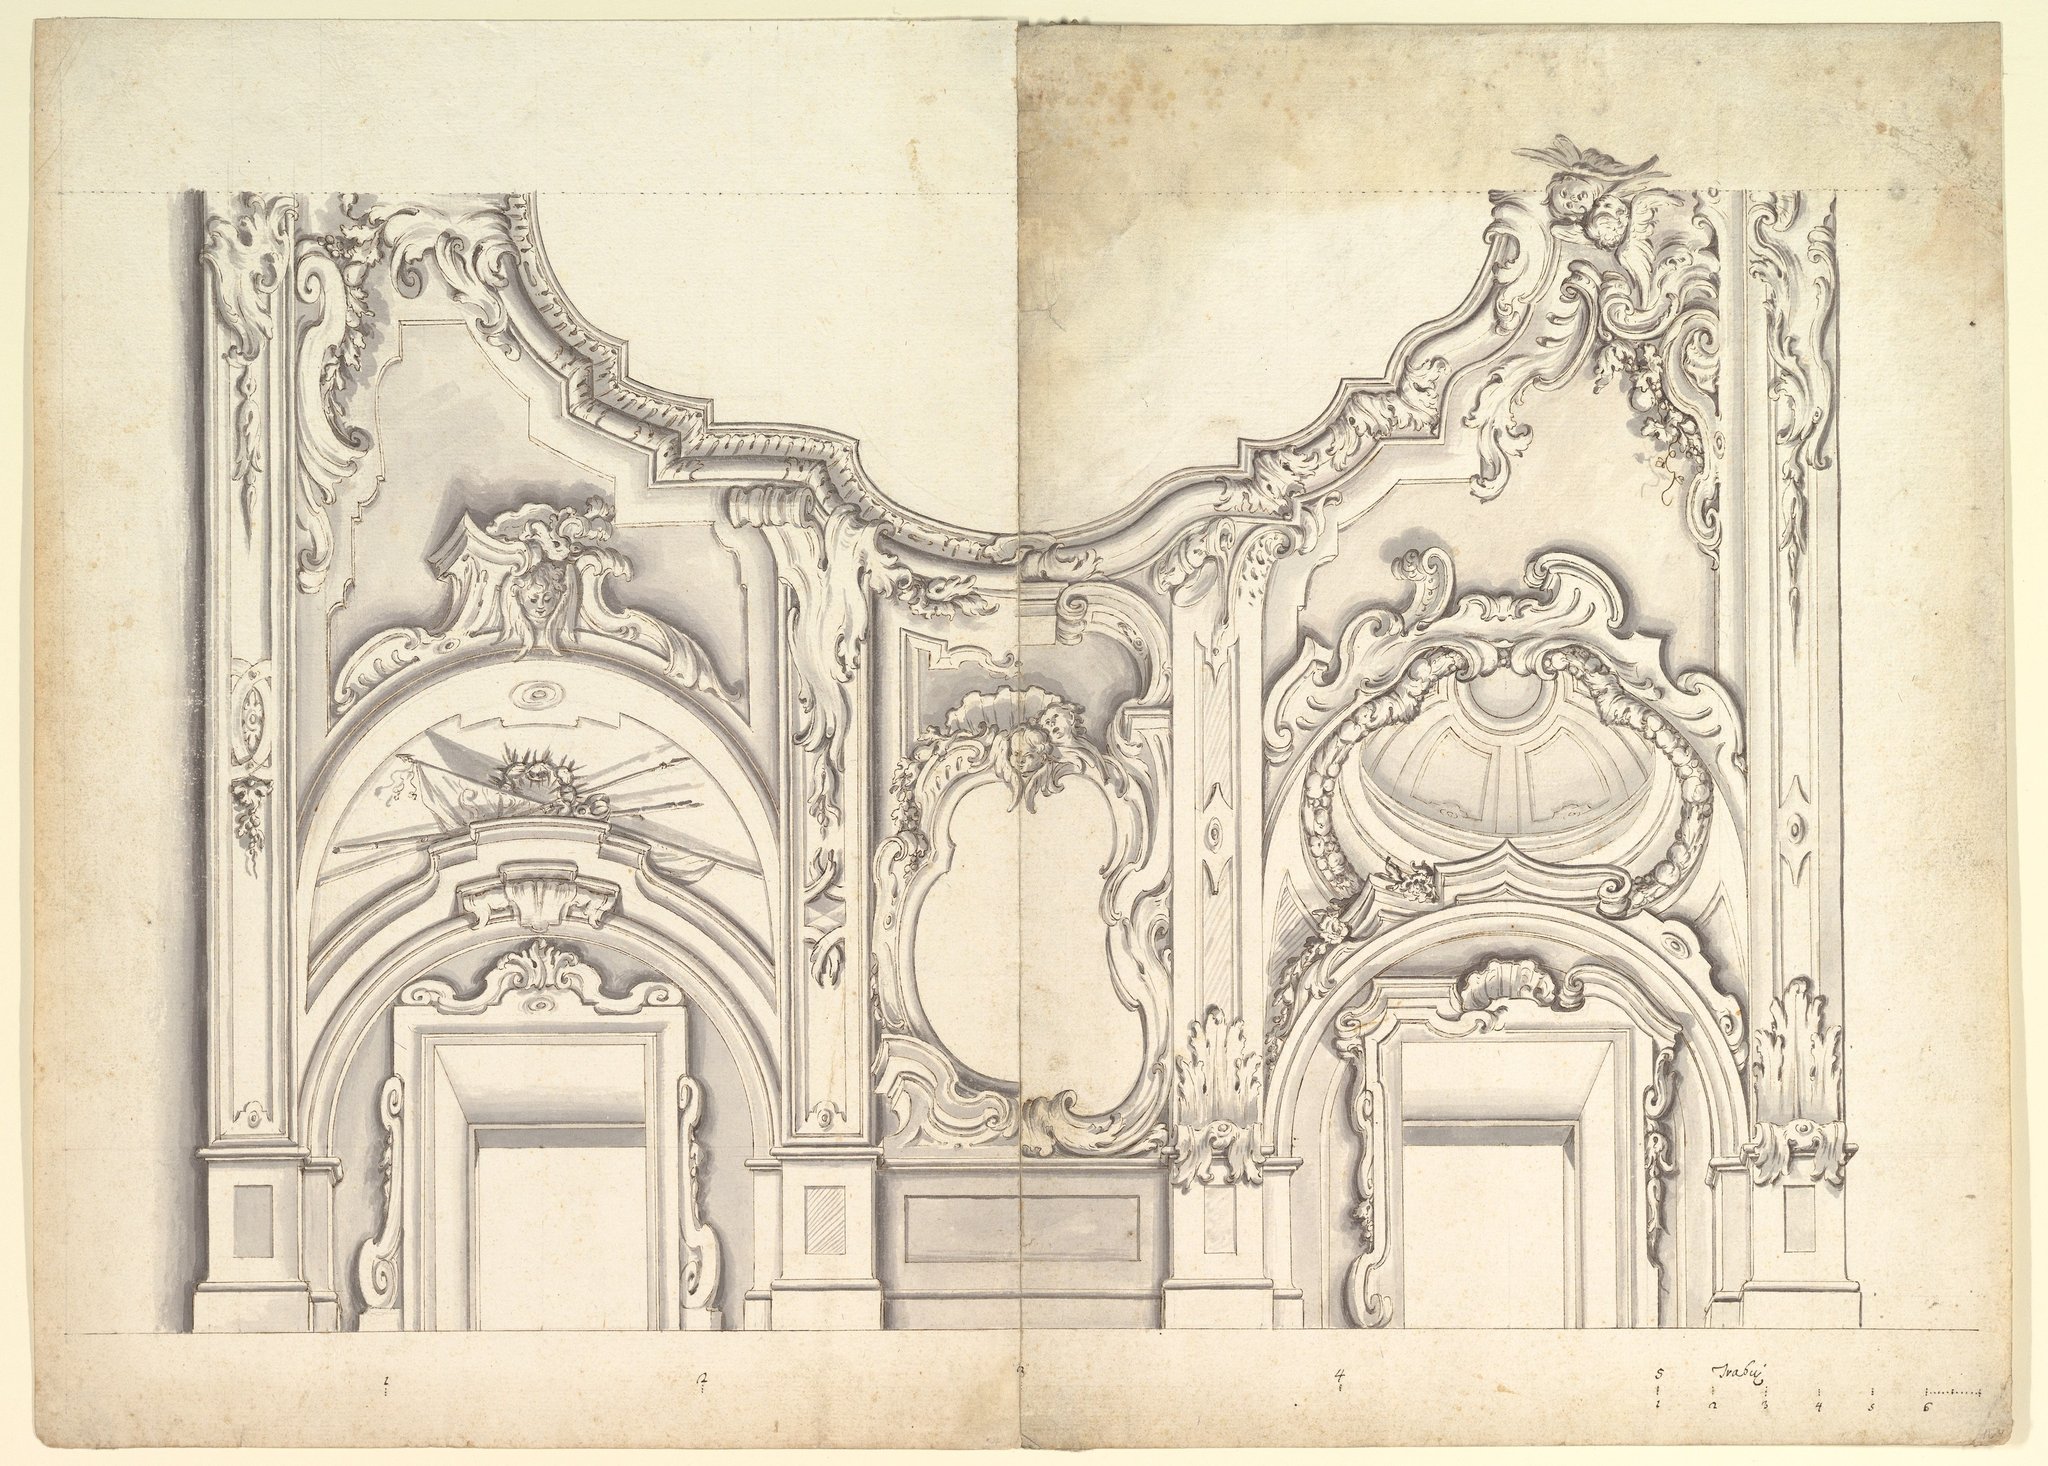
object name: drawing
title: Two Alternate Designs for the Vault of a Chapel with the instruments of the Passion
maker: anonymous, italian, piedmontese, 18th century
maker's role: artist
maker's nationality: italian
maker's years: 1700-1800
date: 1700-1780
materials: graphite, ink, drawing material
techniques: brush, pen, wash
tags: architecture